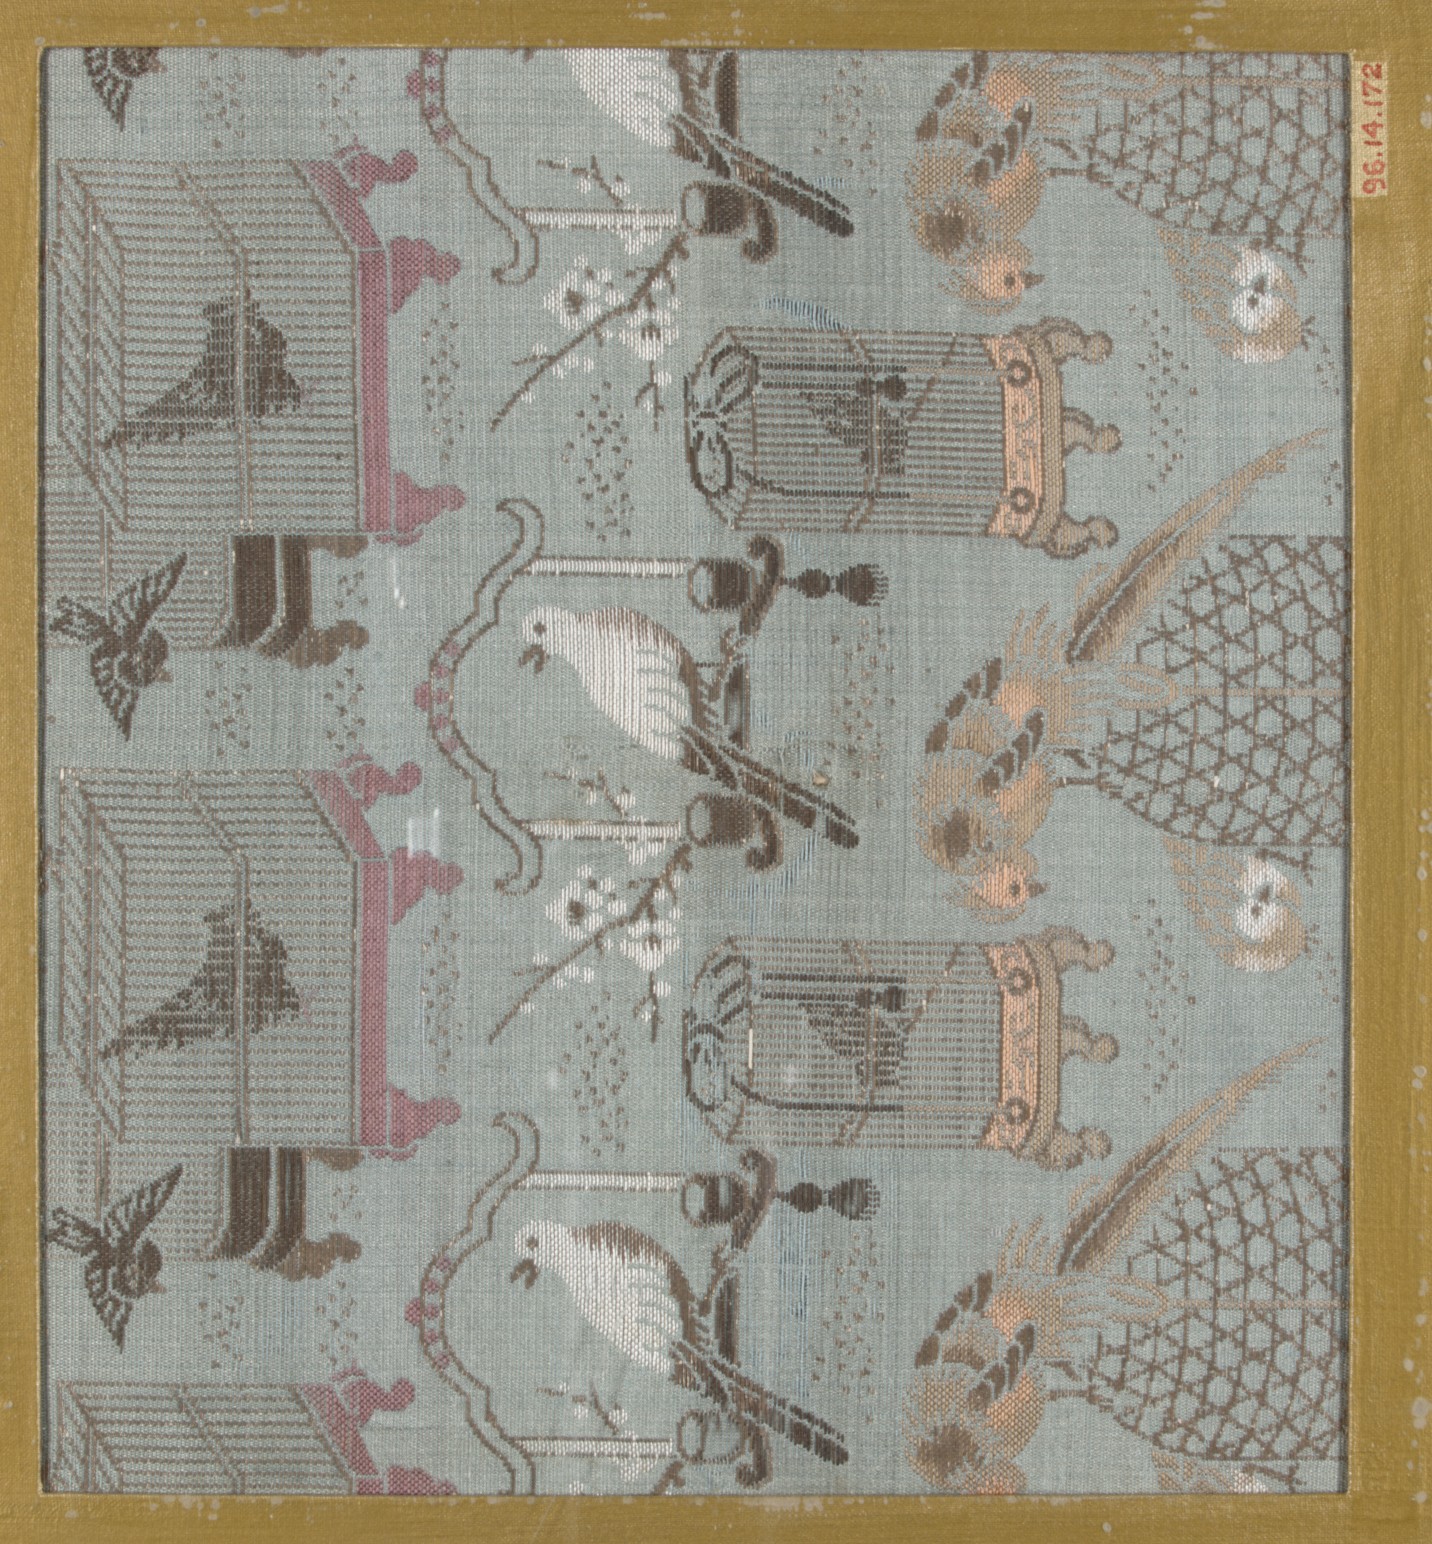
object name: fragment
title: Textile fragment with incomplete repeating pattern of birds and bird cages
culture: japanese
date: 1701-1900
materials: silk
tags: birds